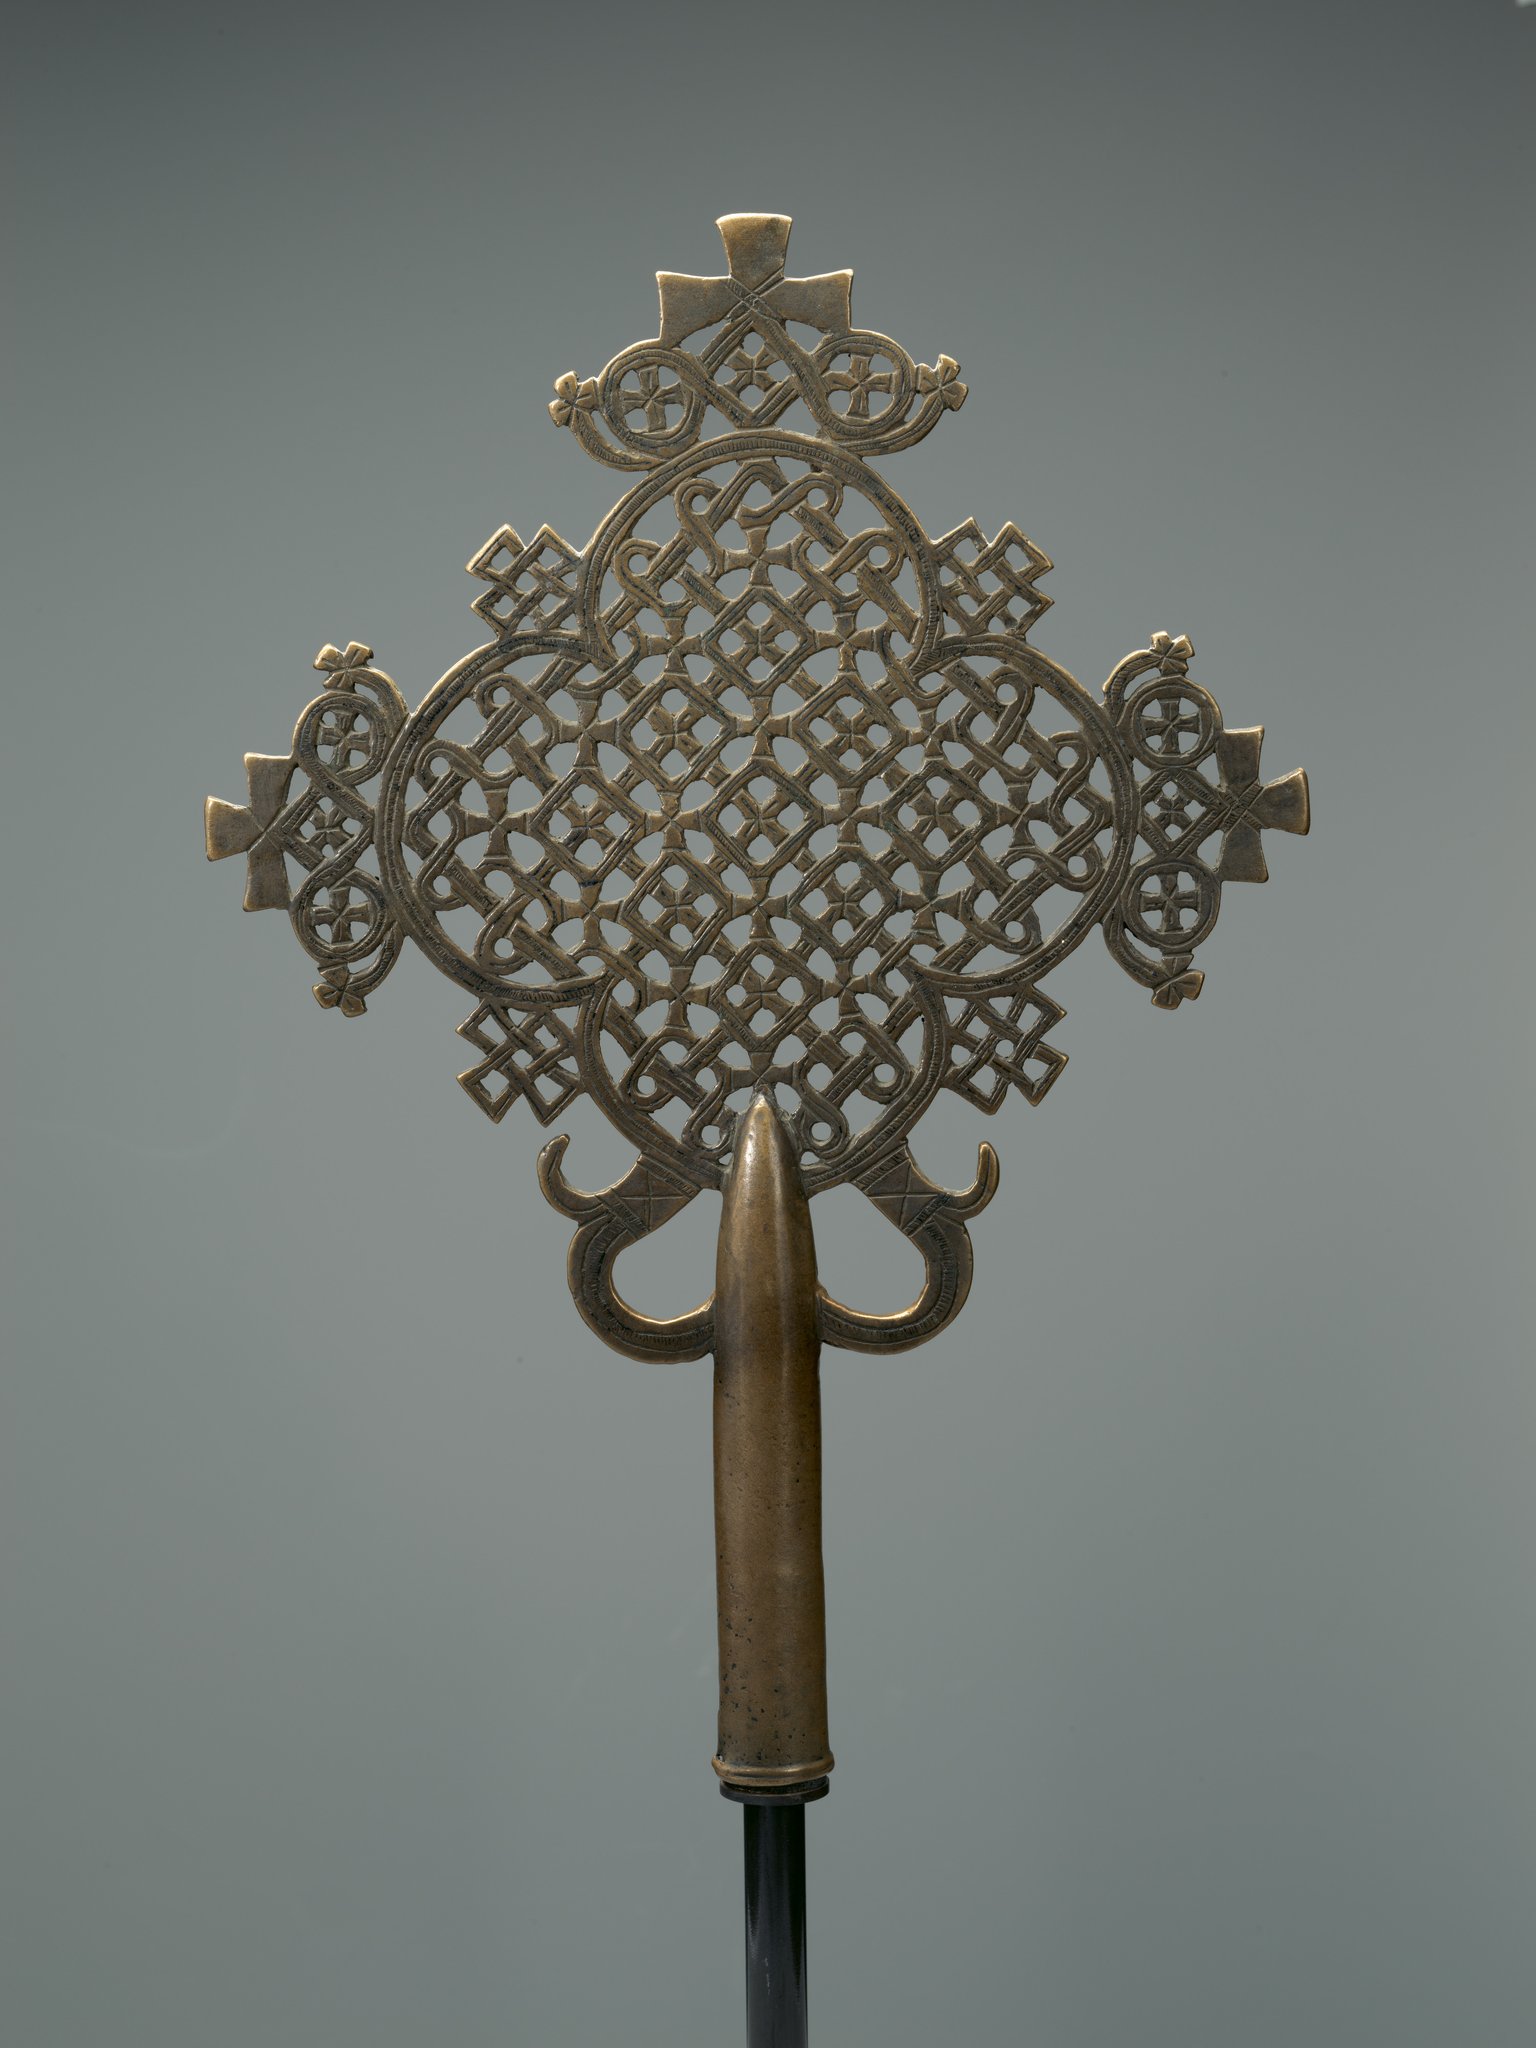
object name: cross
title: Processional Cross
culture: ethiopian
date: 1401-1433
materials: copper alloy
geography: ethiopia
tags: cross